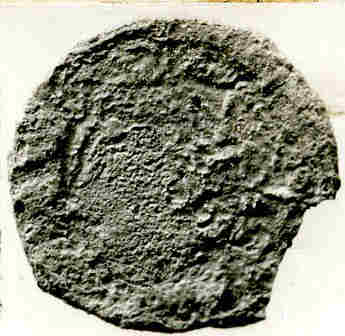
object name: coin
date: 701-900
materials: copper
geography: iran